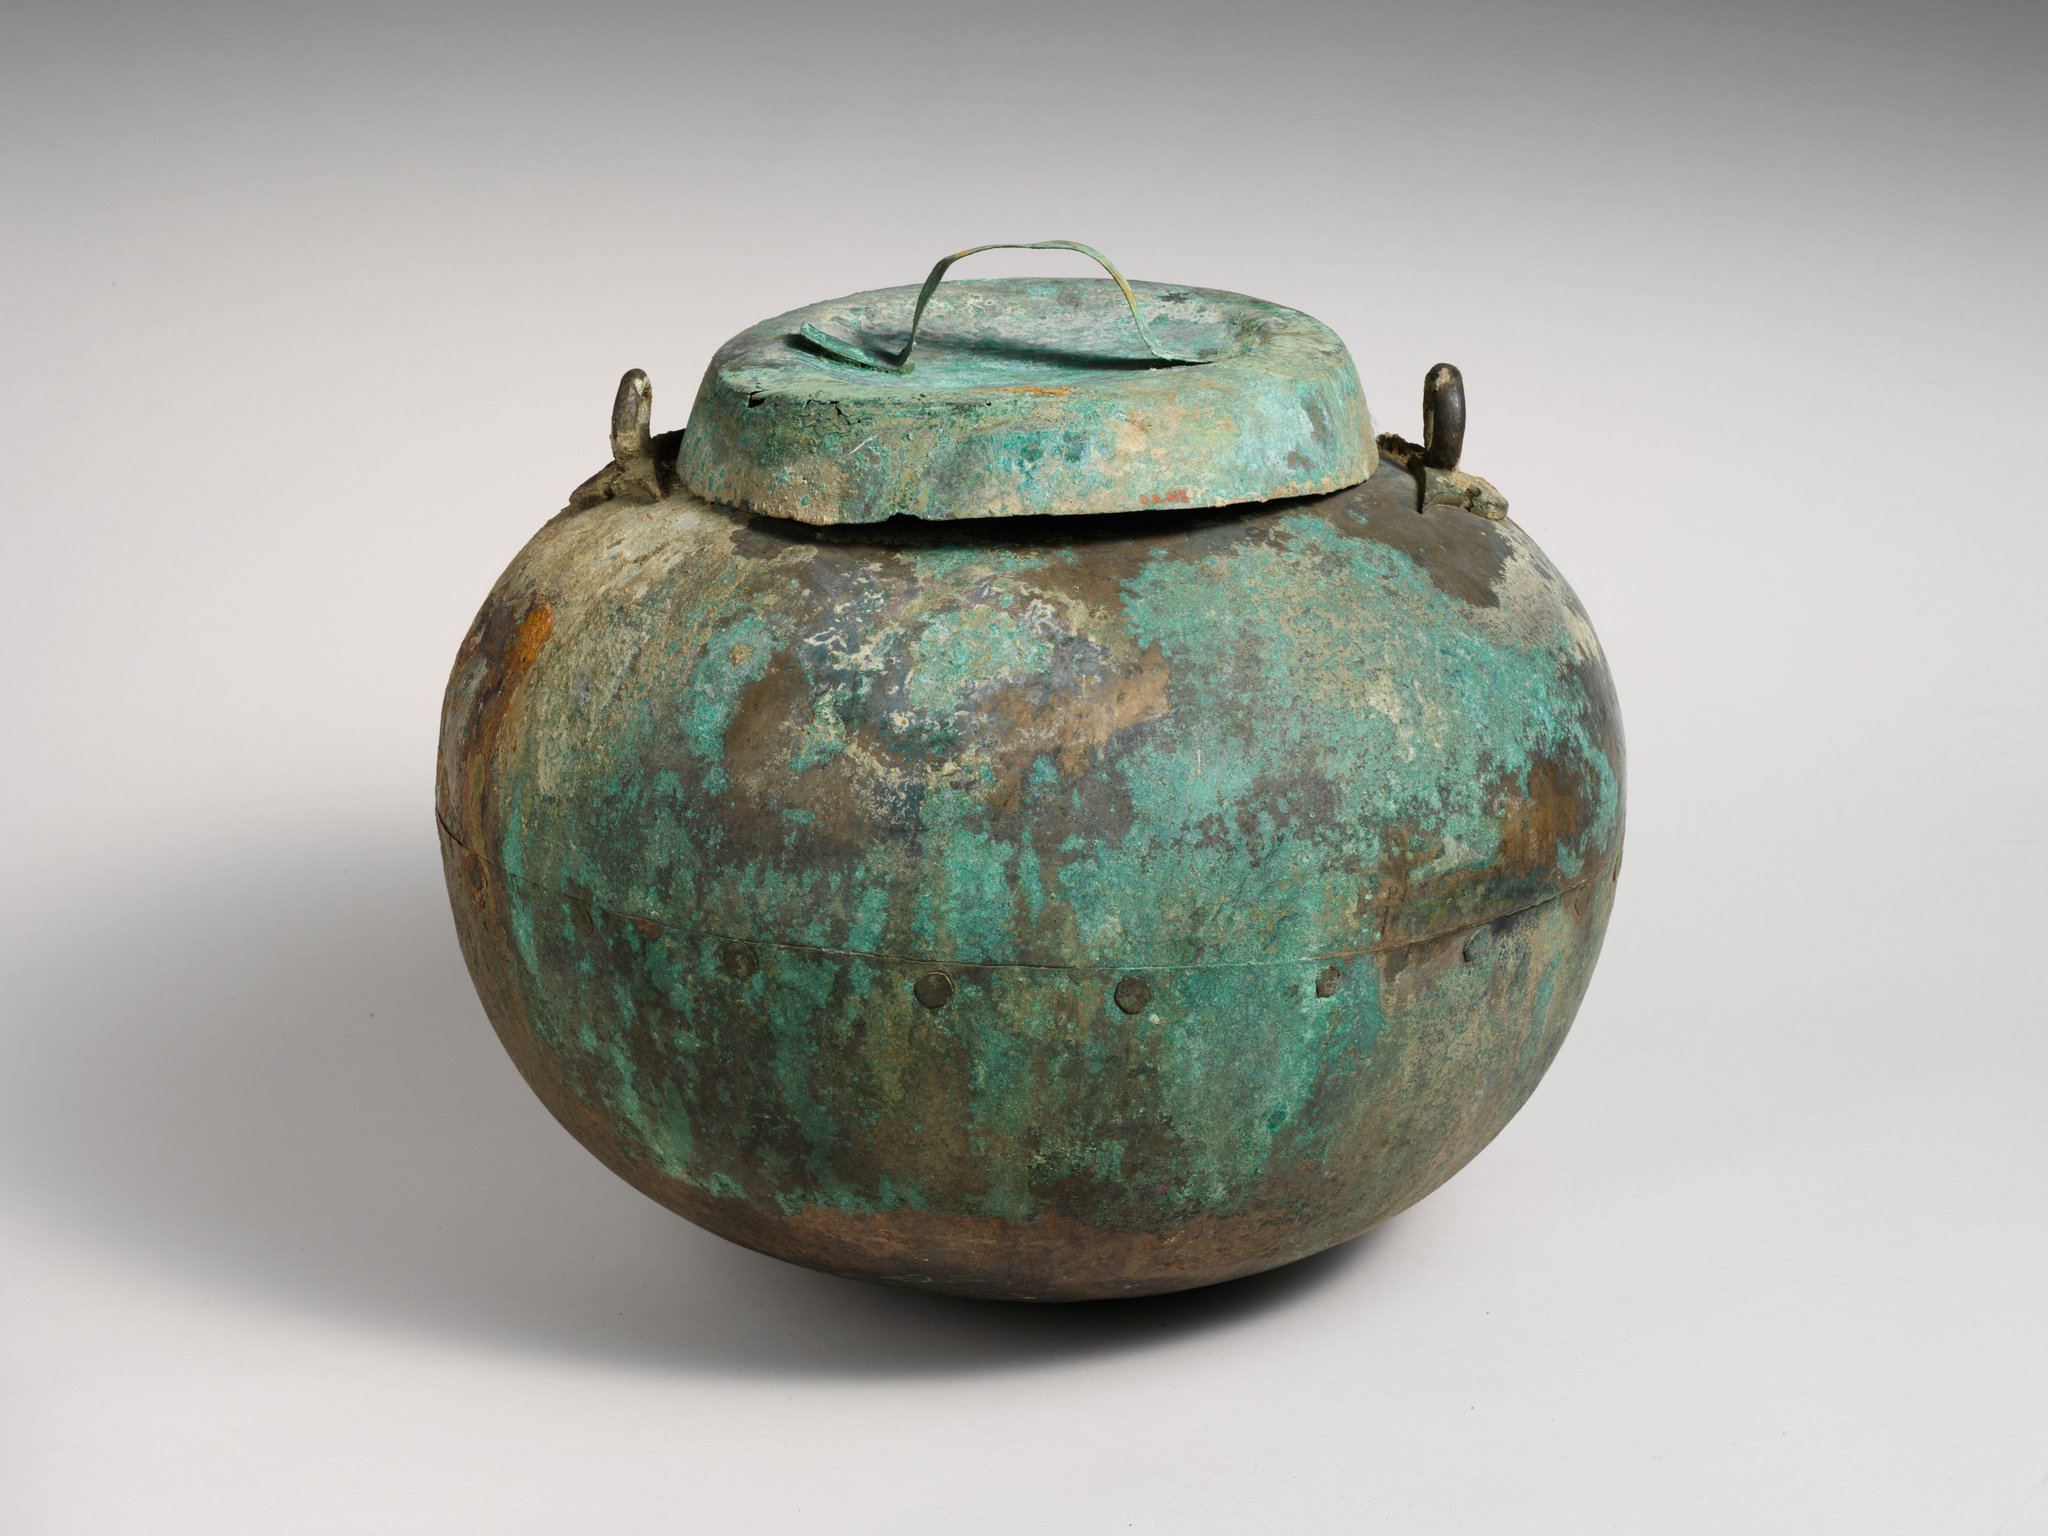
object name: vessel with lid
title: Bronze lid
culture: etruscan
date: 550-525 BCE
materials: bronze